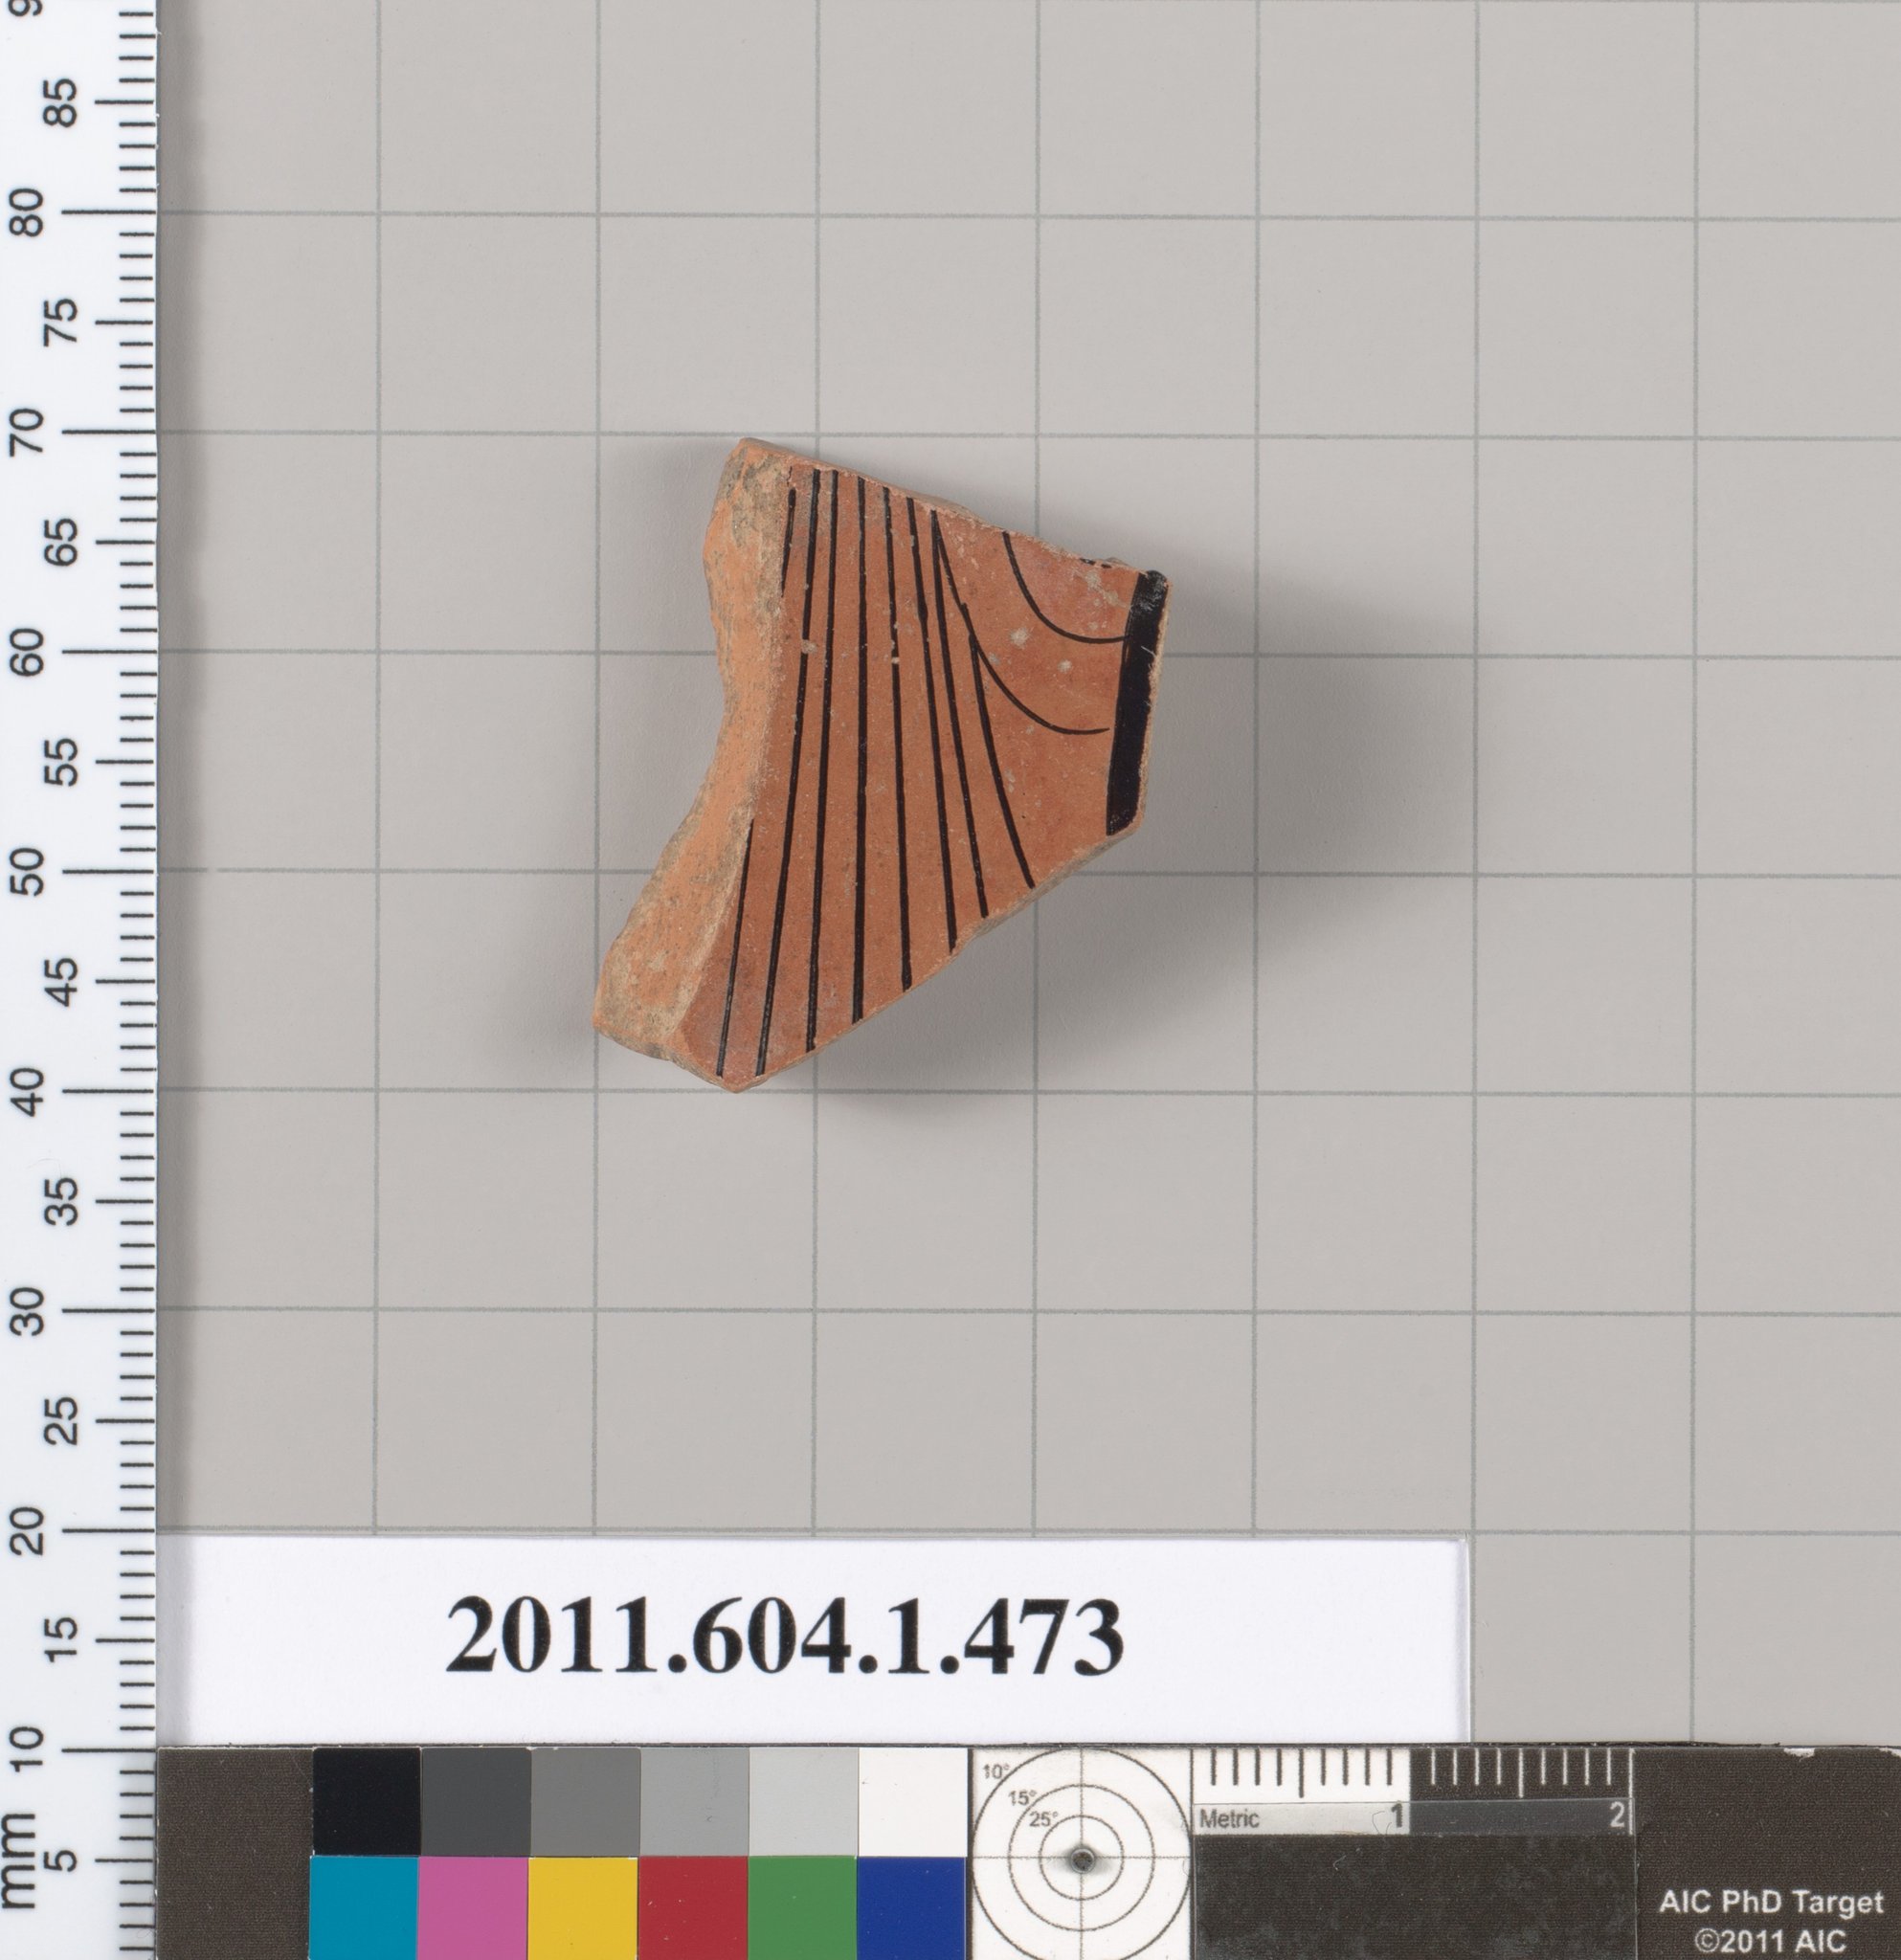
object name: kylix fragment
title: Terracotta fragment of a kylix (drinking cup)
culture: greek, attic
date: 490-480 BCE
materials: terracotta